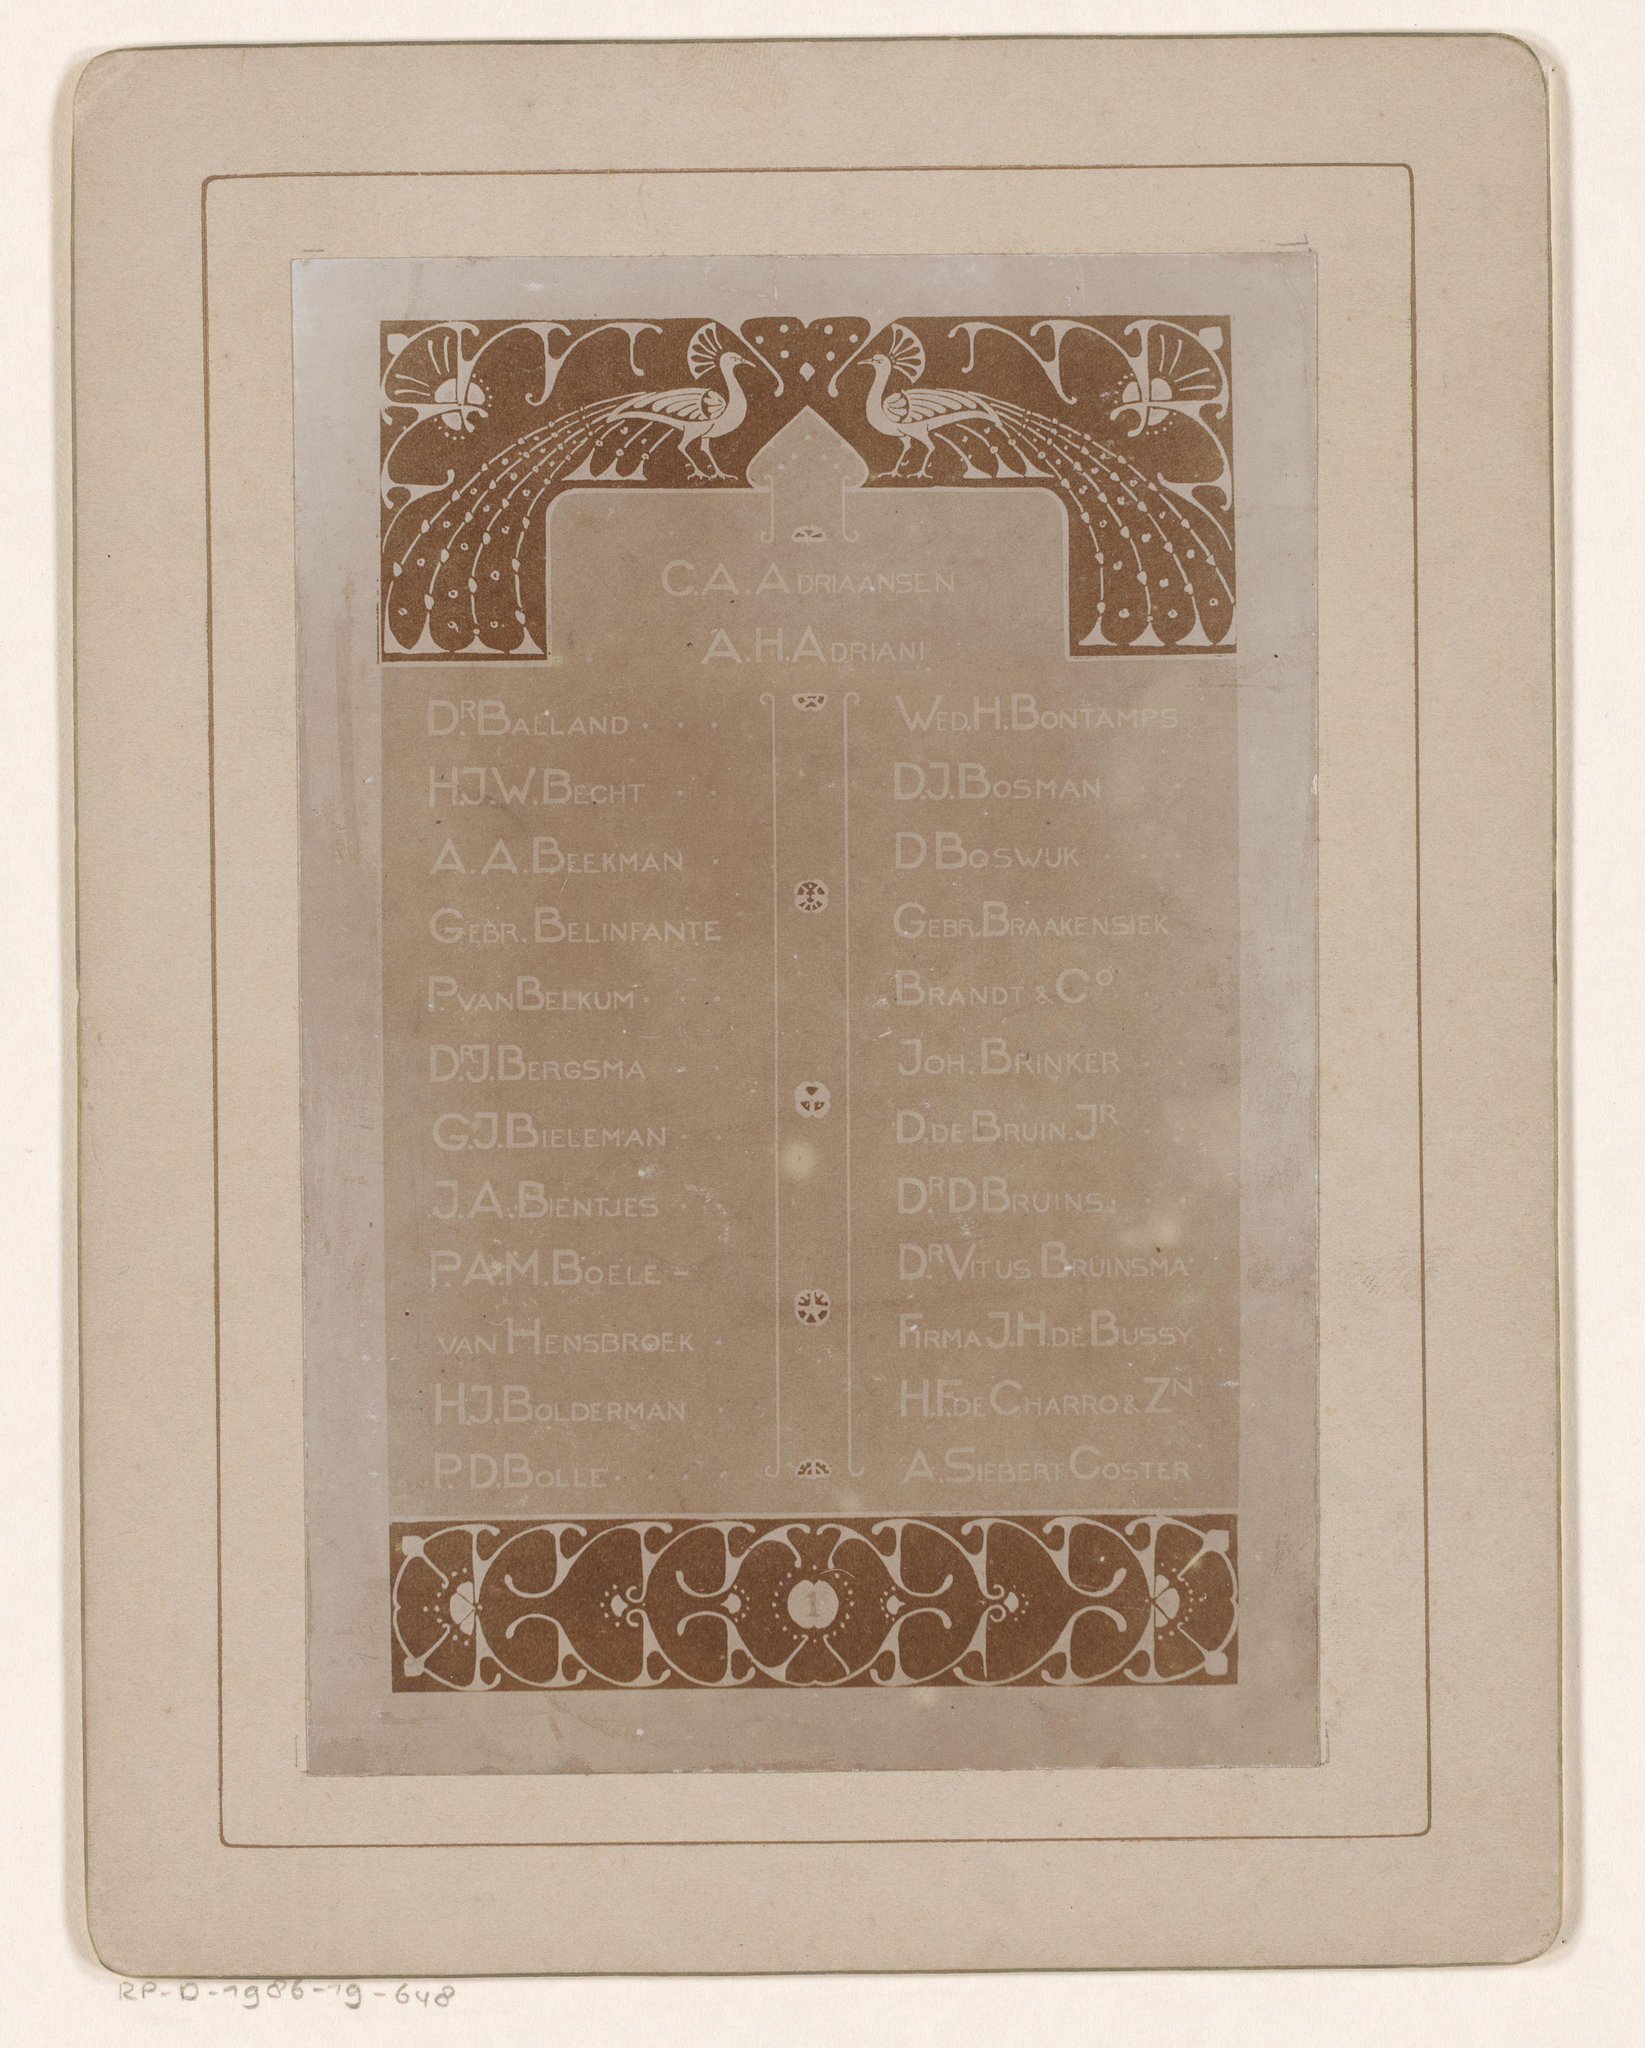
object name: photograph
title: Albumblad met namenlijst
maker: Anonymous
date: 1886-1900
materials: cardboard, photographic support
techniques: collodion silver print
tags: ornamental birds: peacock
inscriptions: name: ‘R.W.P. de Vries Jr’, annotation: ‘album blad/ J.W. Schillemans’, collector's mark: ‘R:MVS.’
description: Albumblad met een titelhoofd met twee pauwen, ornamenten en een lijst met namen. Het blad is afkomstig uit een album voor J.W. Schellemans of Schillemans.